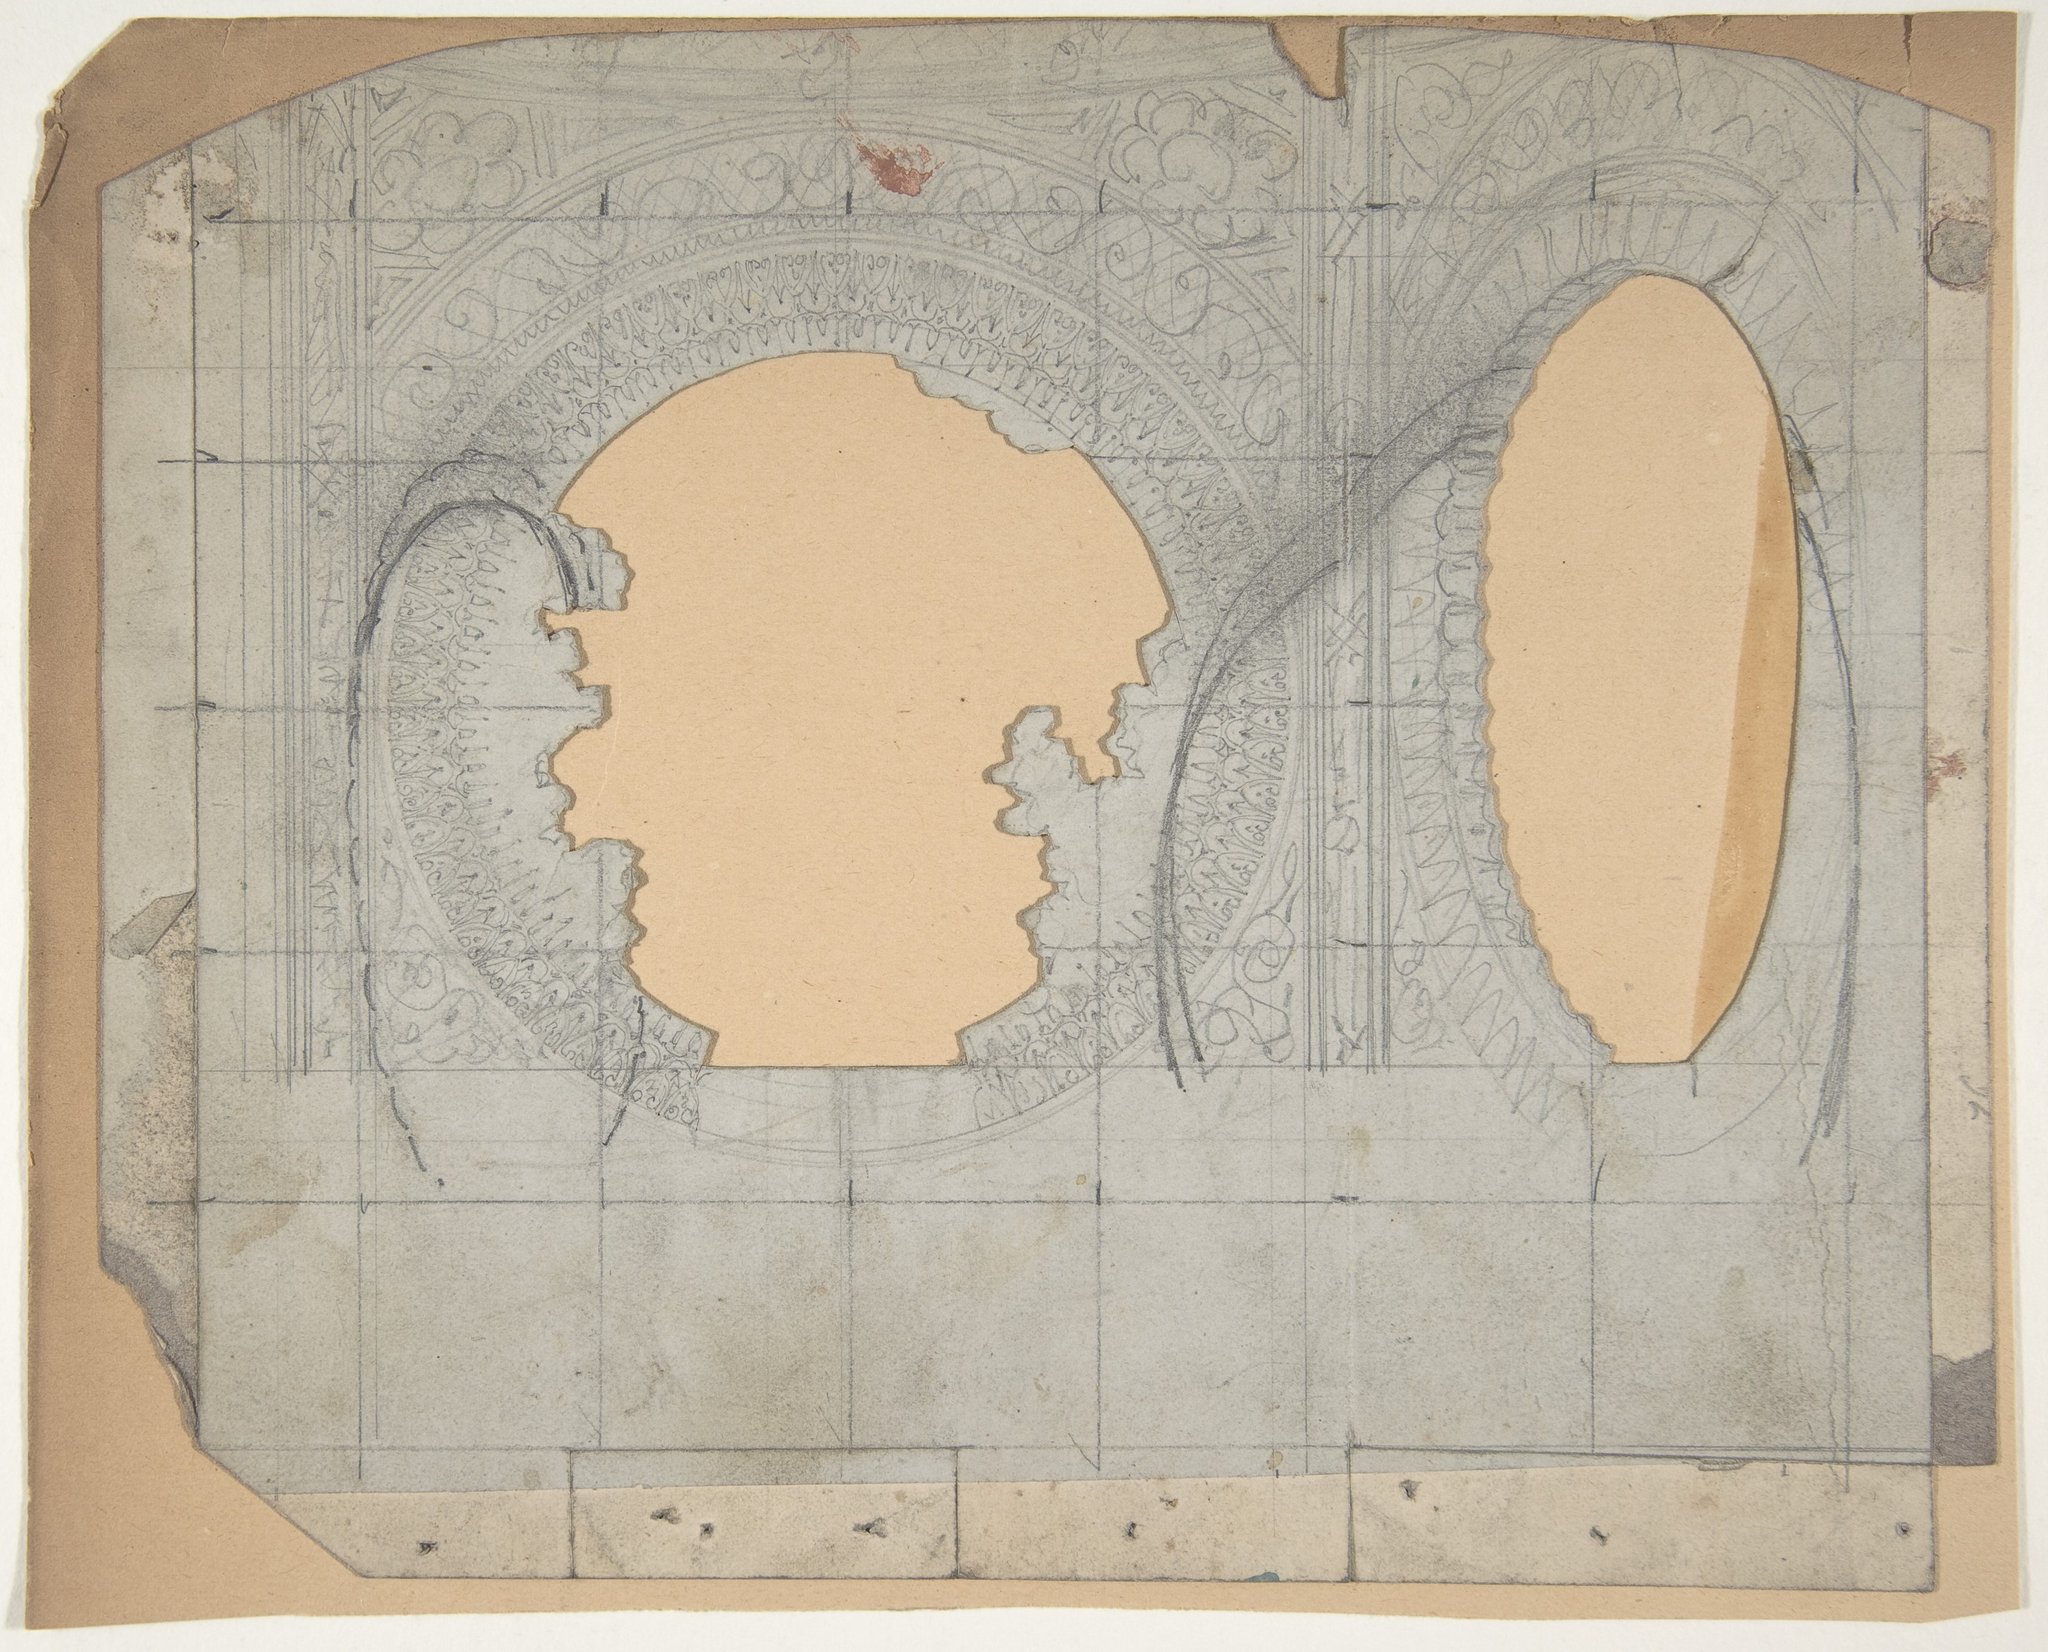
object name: drawing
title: Design for a Stage Set at the Opéra, Paris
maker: eugène cicéri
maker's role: artist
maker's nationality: french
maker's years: 1813-1890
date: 1830-1890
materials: graphite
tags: stage design